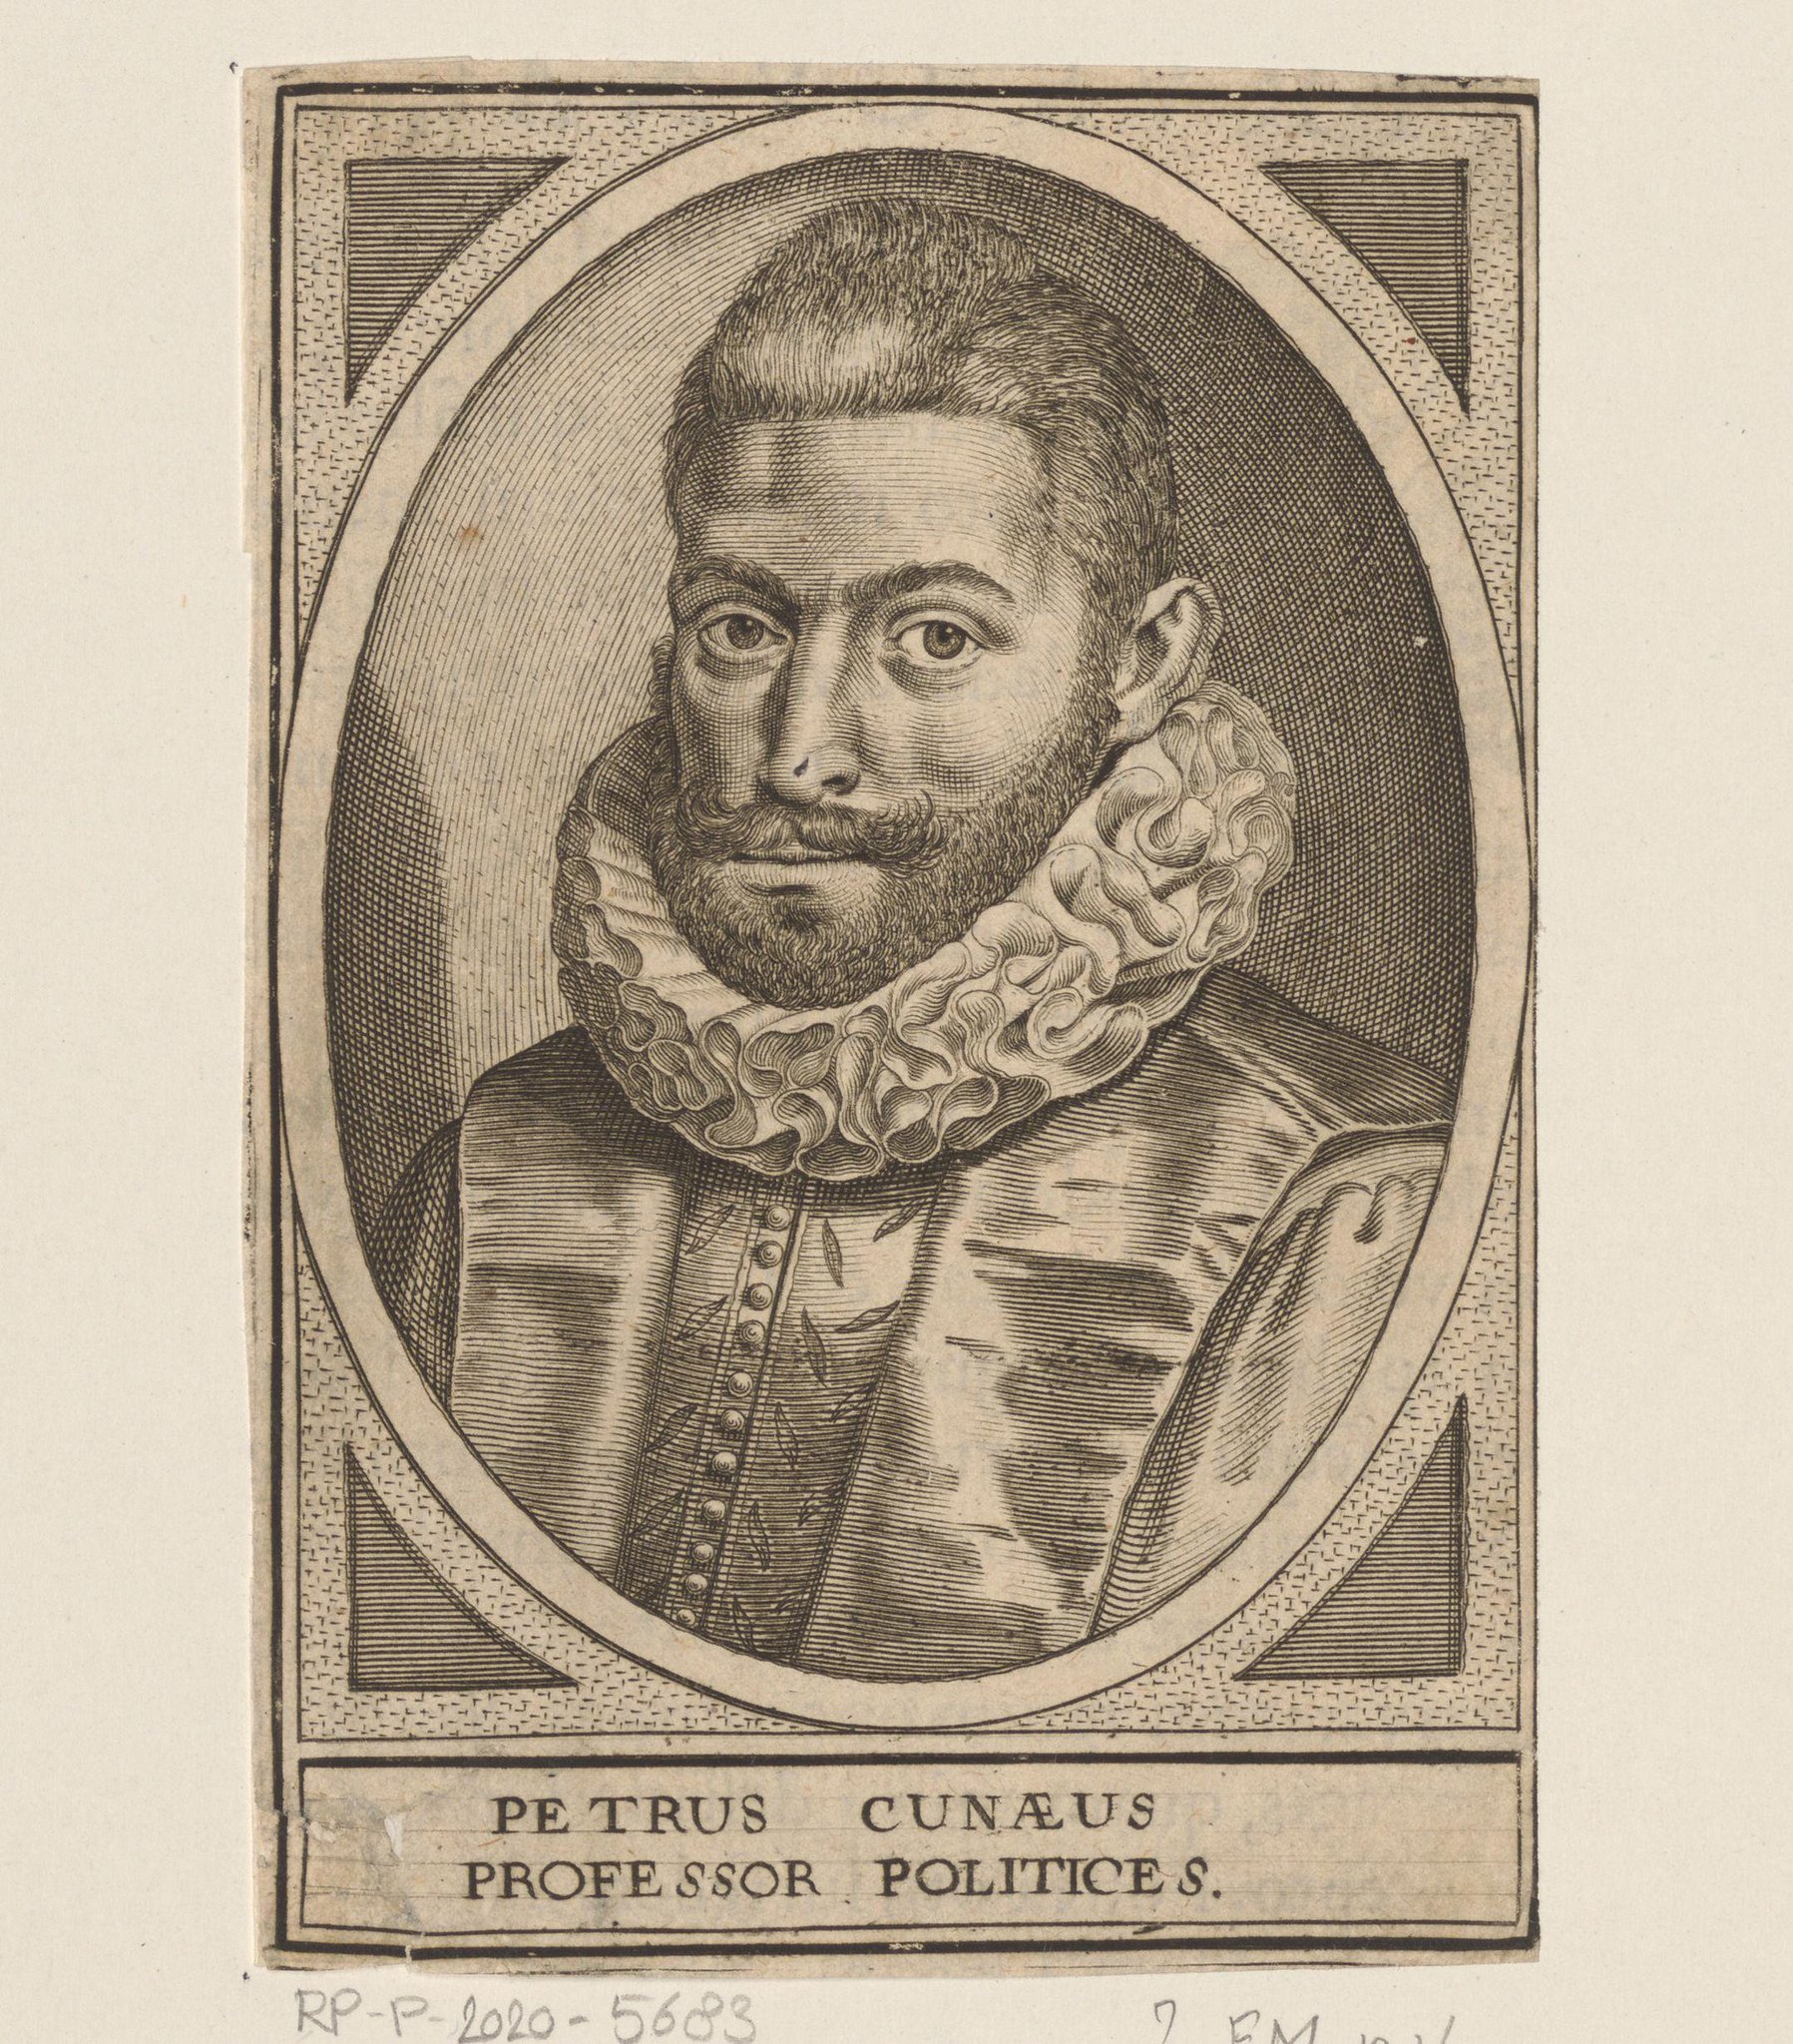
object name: book illustration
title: Portret van Petrus Cunaeus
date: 1614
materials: paper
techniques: engraving, letterpress printing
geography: leiden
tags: flushing, leiden, historical persons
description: Prent uit: Meurs, Johannes. Illustrium Hollandiae et Westfrisiae ordinum alma Academia Leidensis. Leiden: Jacob Marcus, 1614, p. 221.